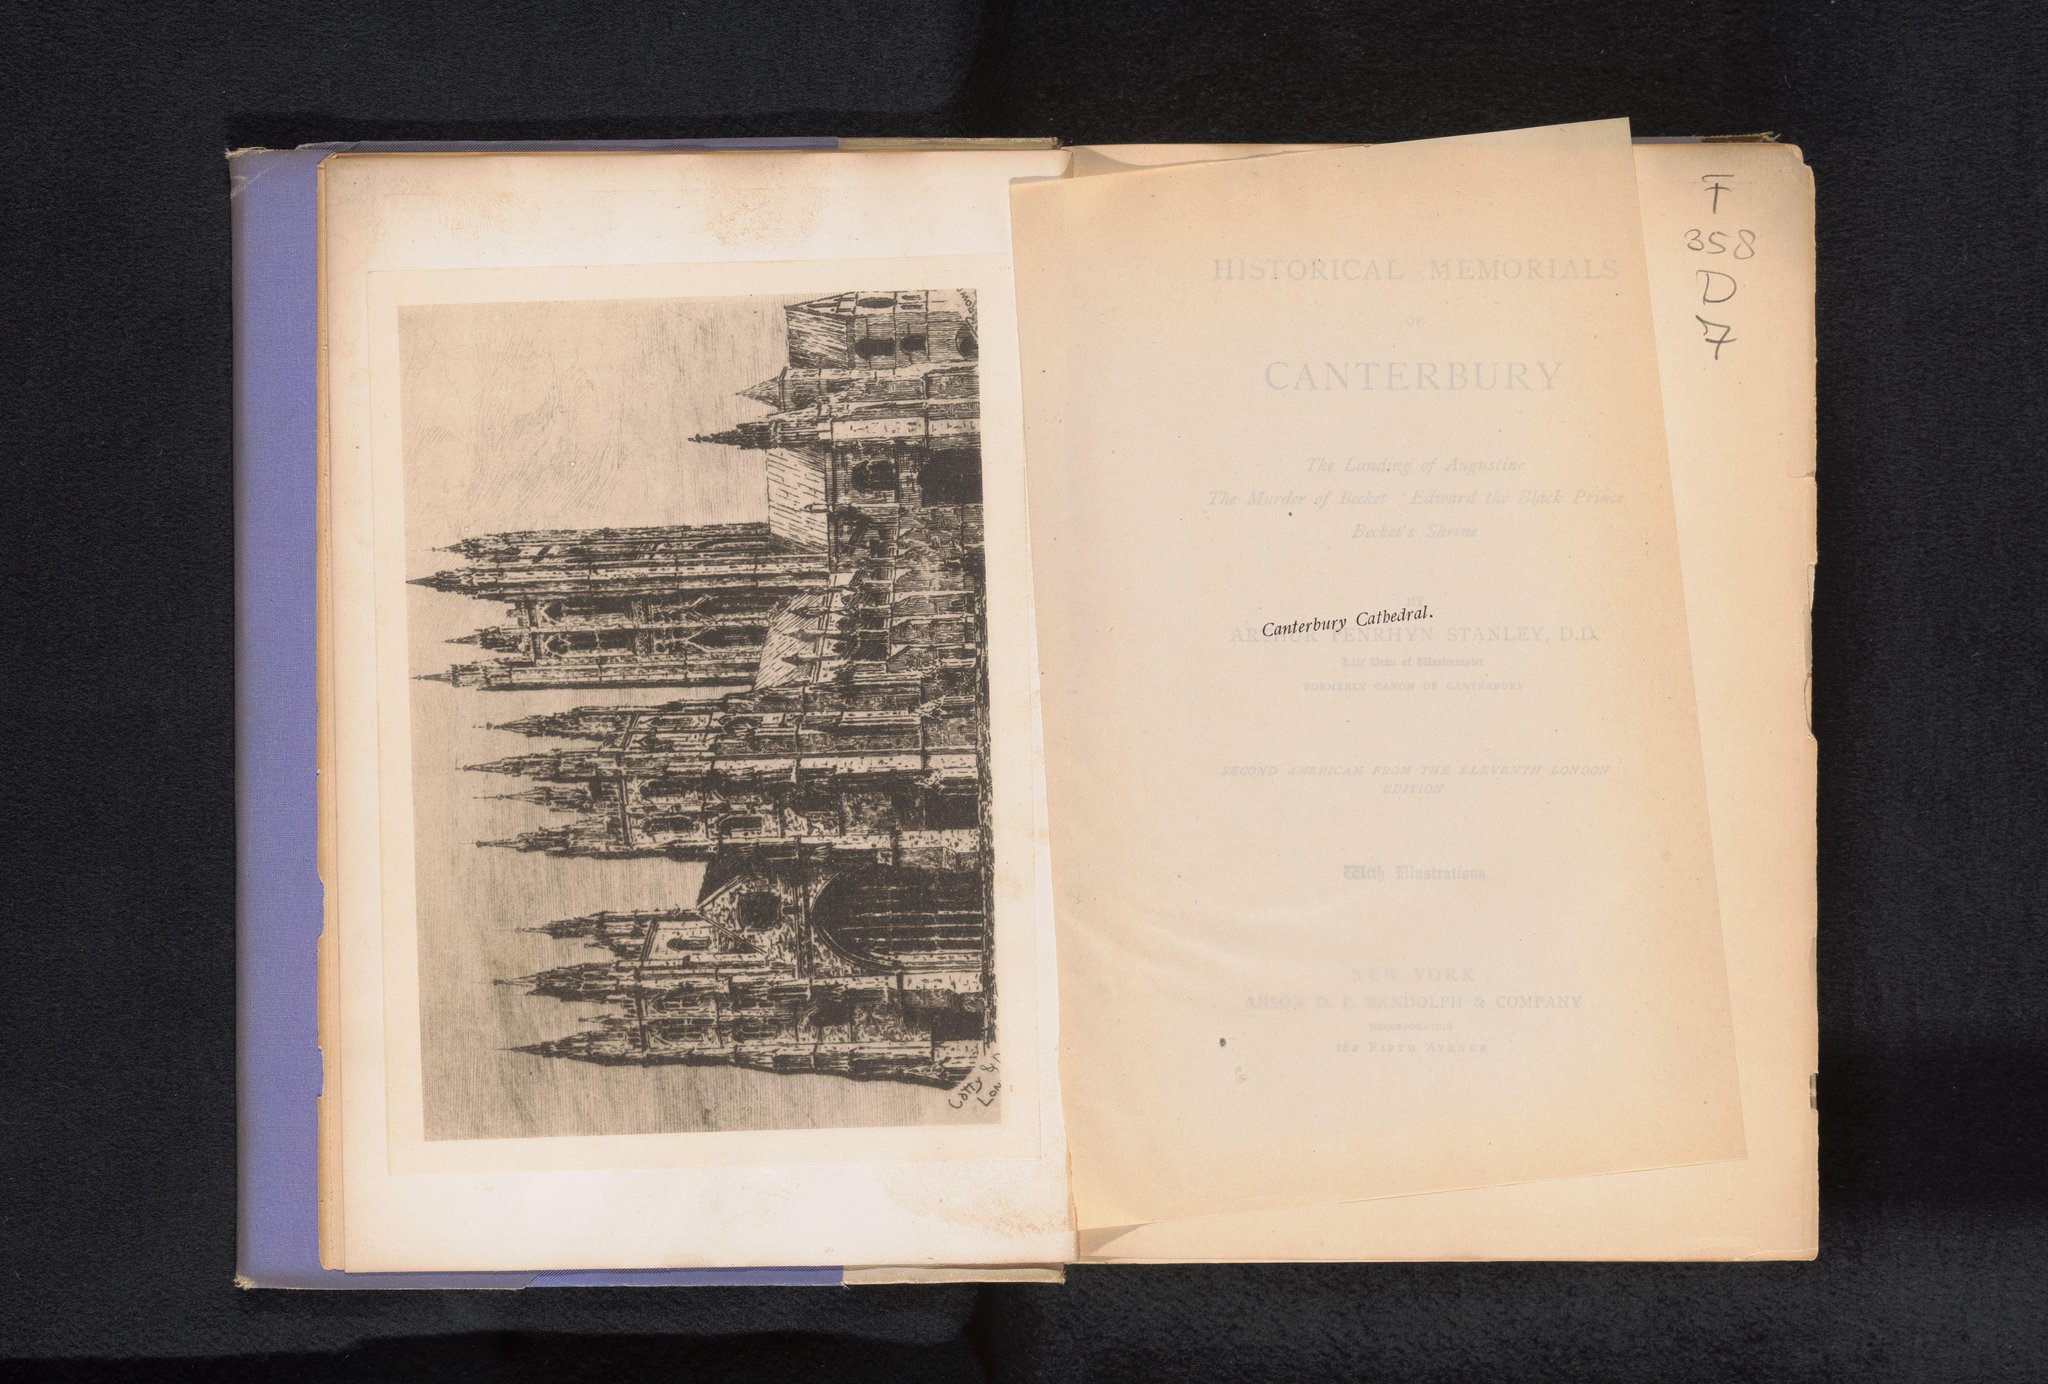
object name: photomechanical print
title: Canterbury Cathedral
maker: Anonymous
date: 1882-1892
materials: paper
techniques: photograph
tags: church (exterior)